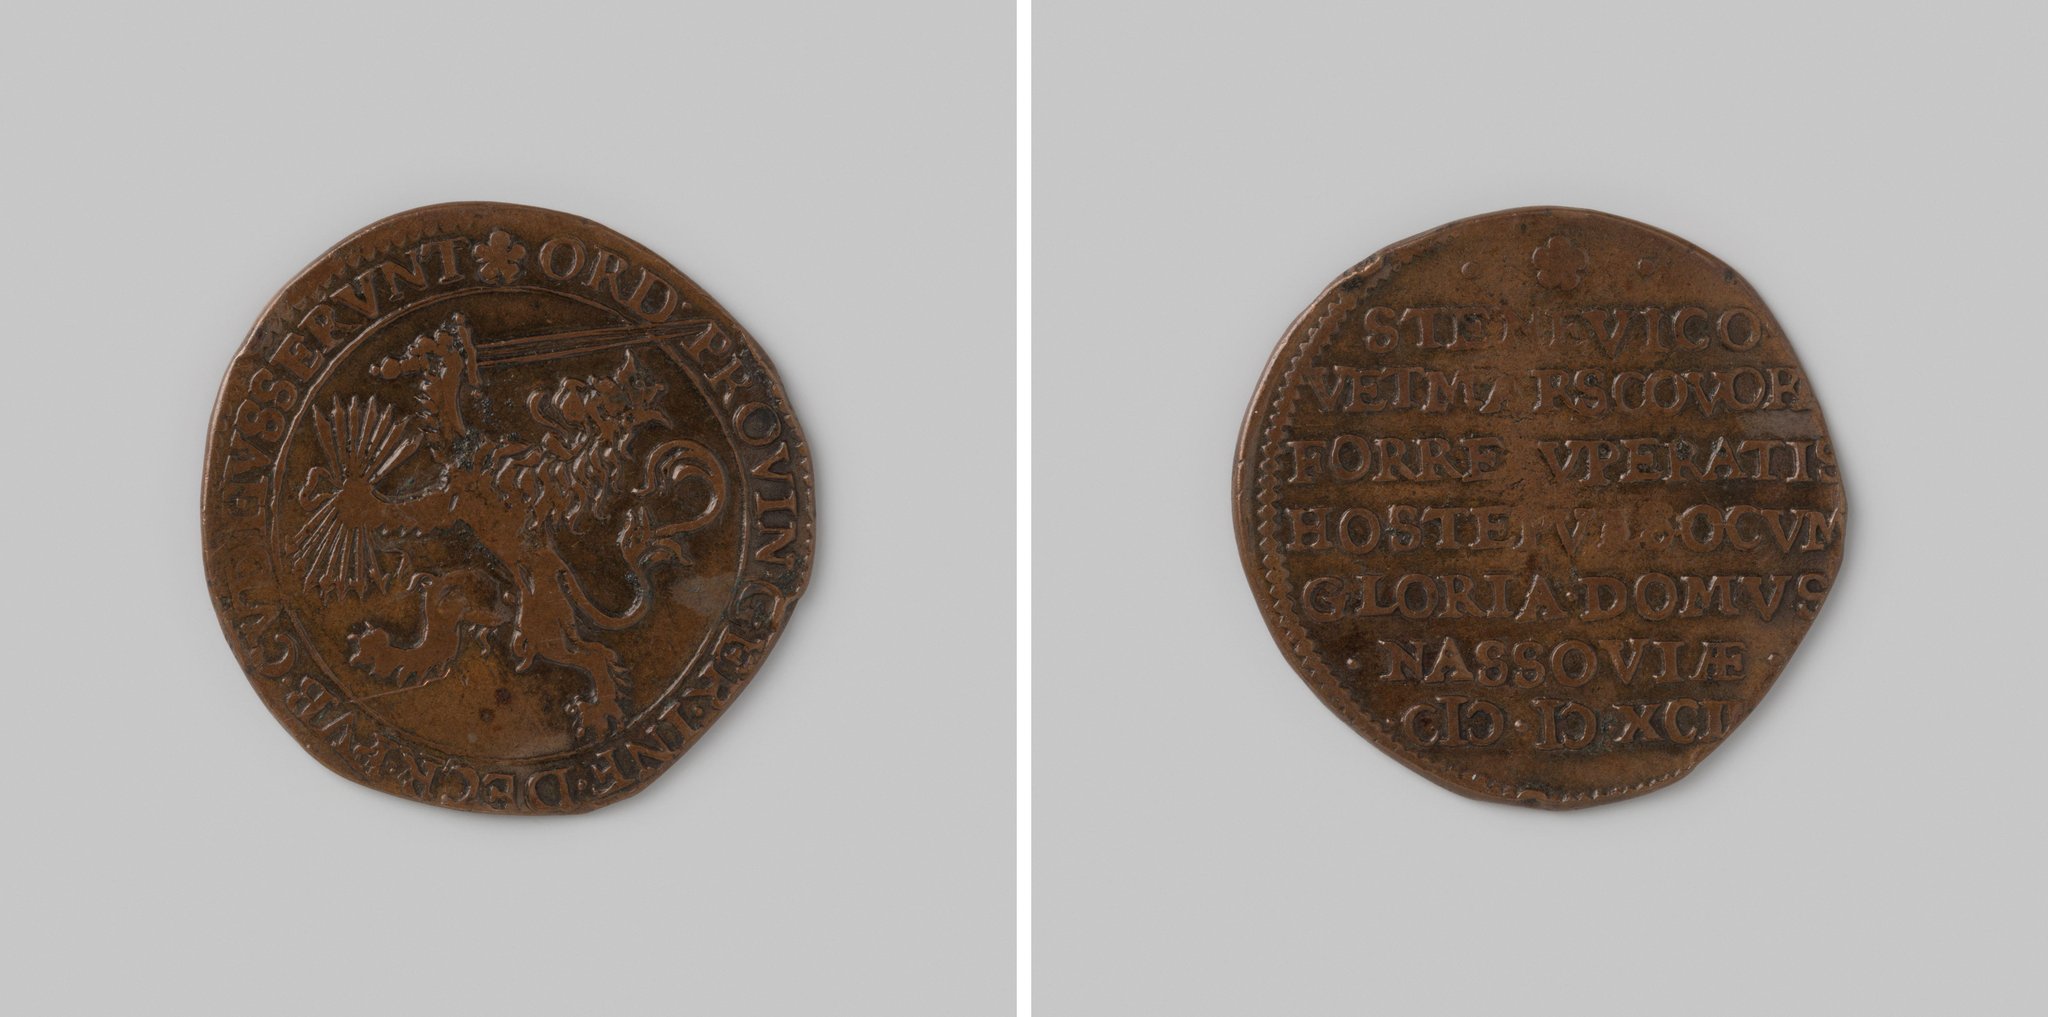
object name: jeton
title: Rekenpenning uit Dordrecht op de inname van Steenwijk, Ootmarsum en Koevorden 1592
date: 1592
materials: copper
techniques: striking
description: Koperen penning, op de voorzijde een gekroonde klimmende leeuw naar links met zwaard en pijlenbundel, met omschrift, op de keerzijde zeven regels tekst.